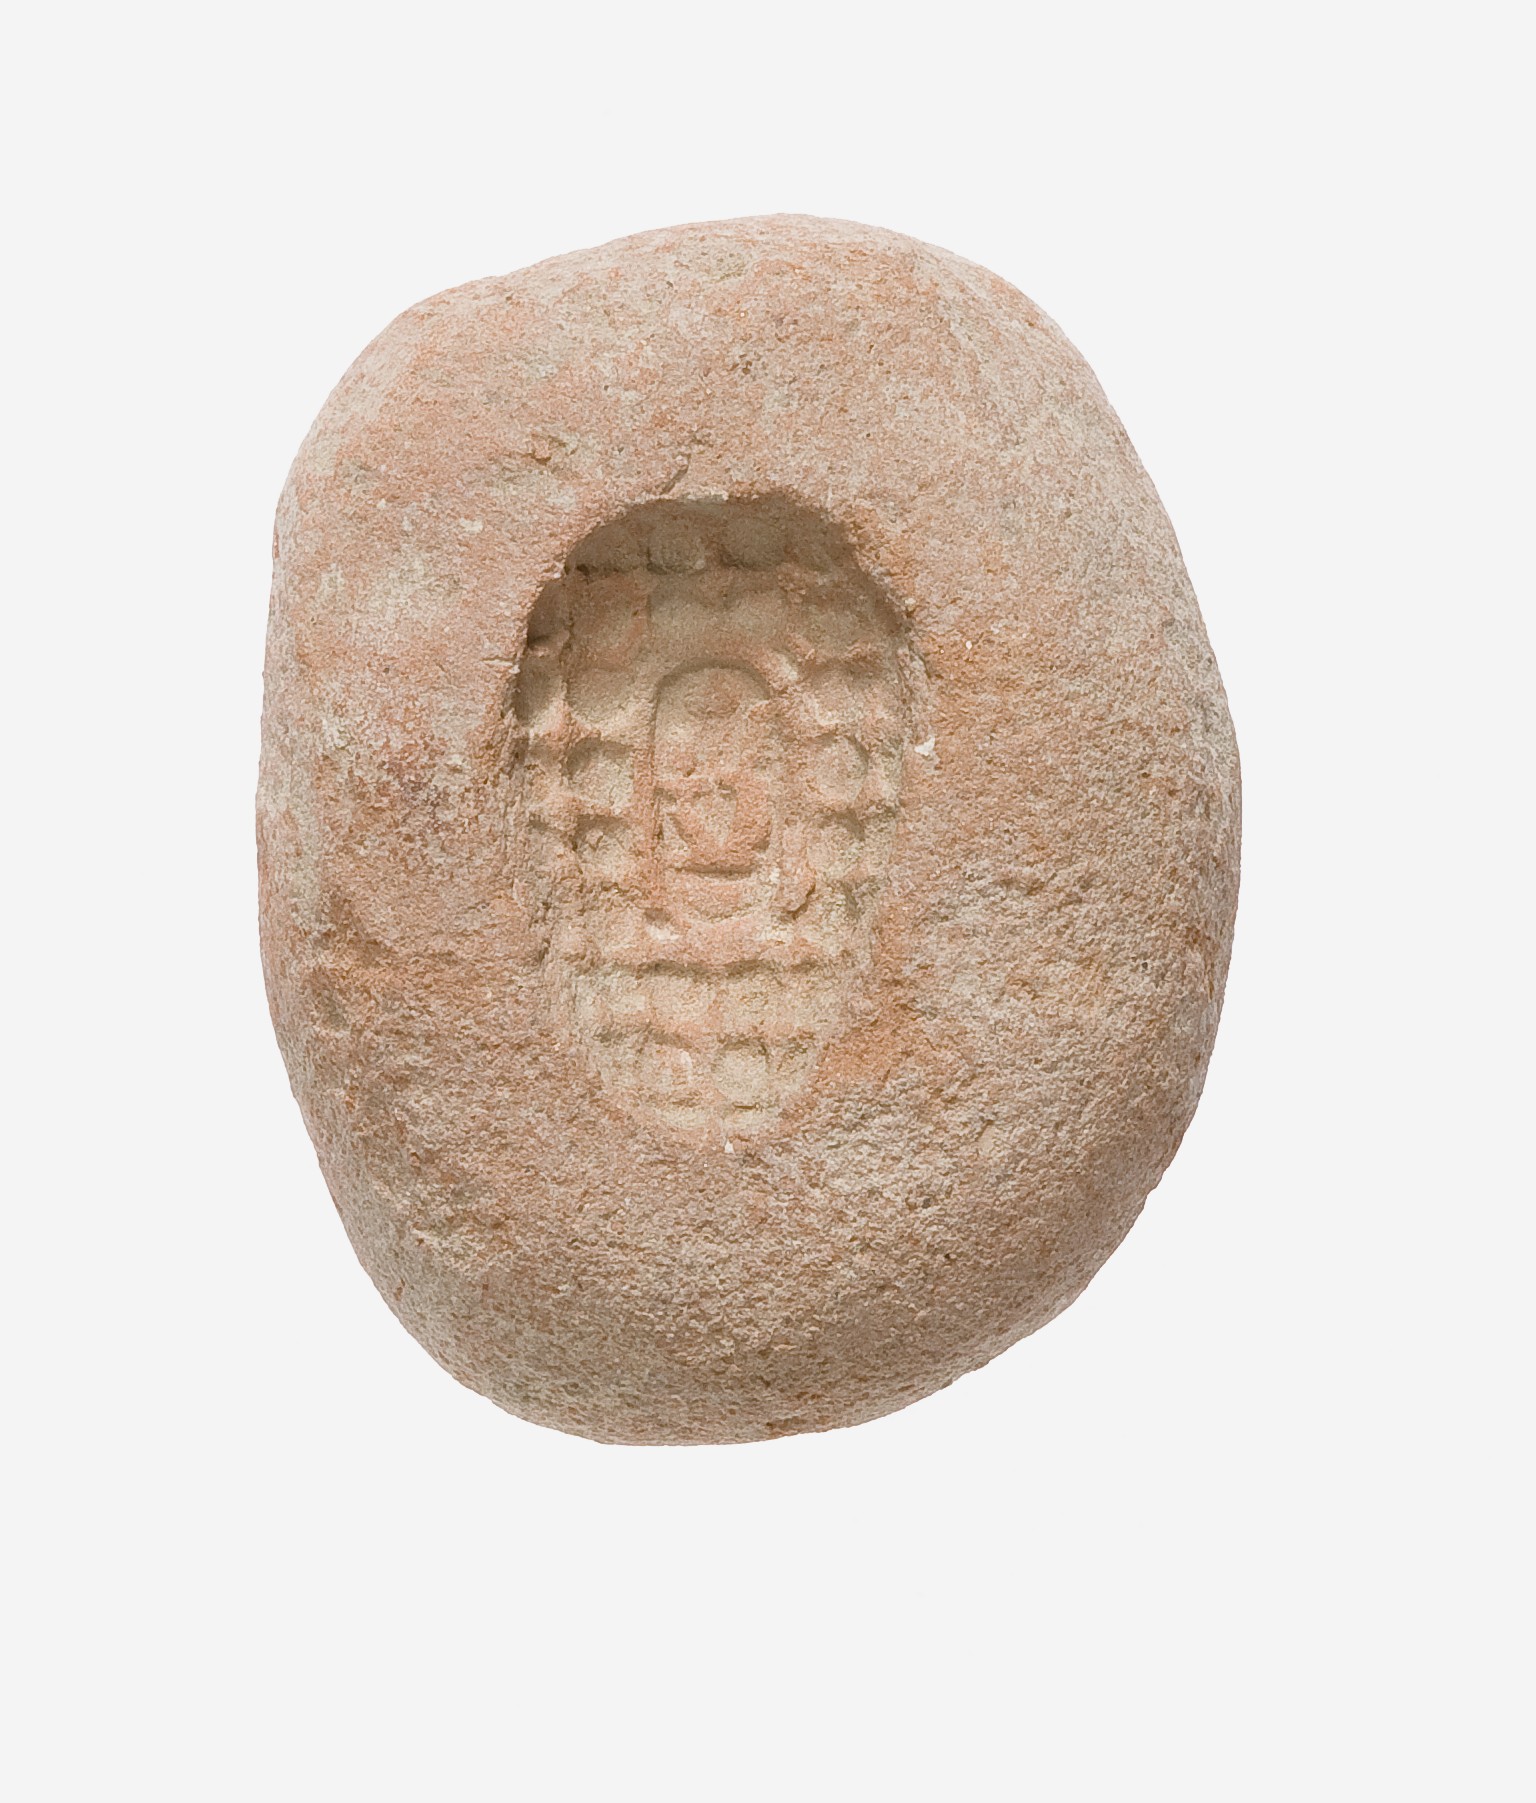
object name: mold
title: Mold: Grapes with Cartouche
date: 1390-1352 BCE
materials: pottery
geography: egypt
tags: cartouches